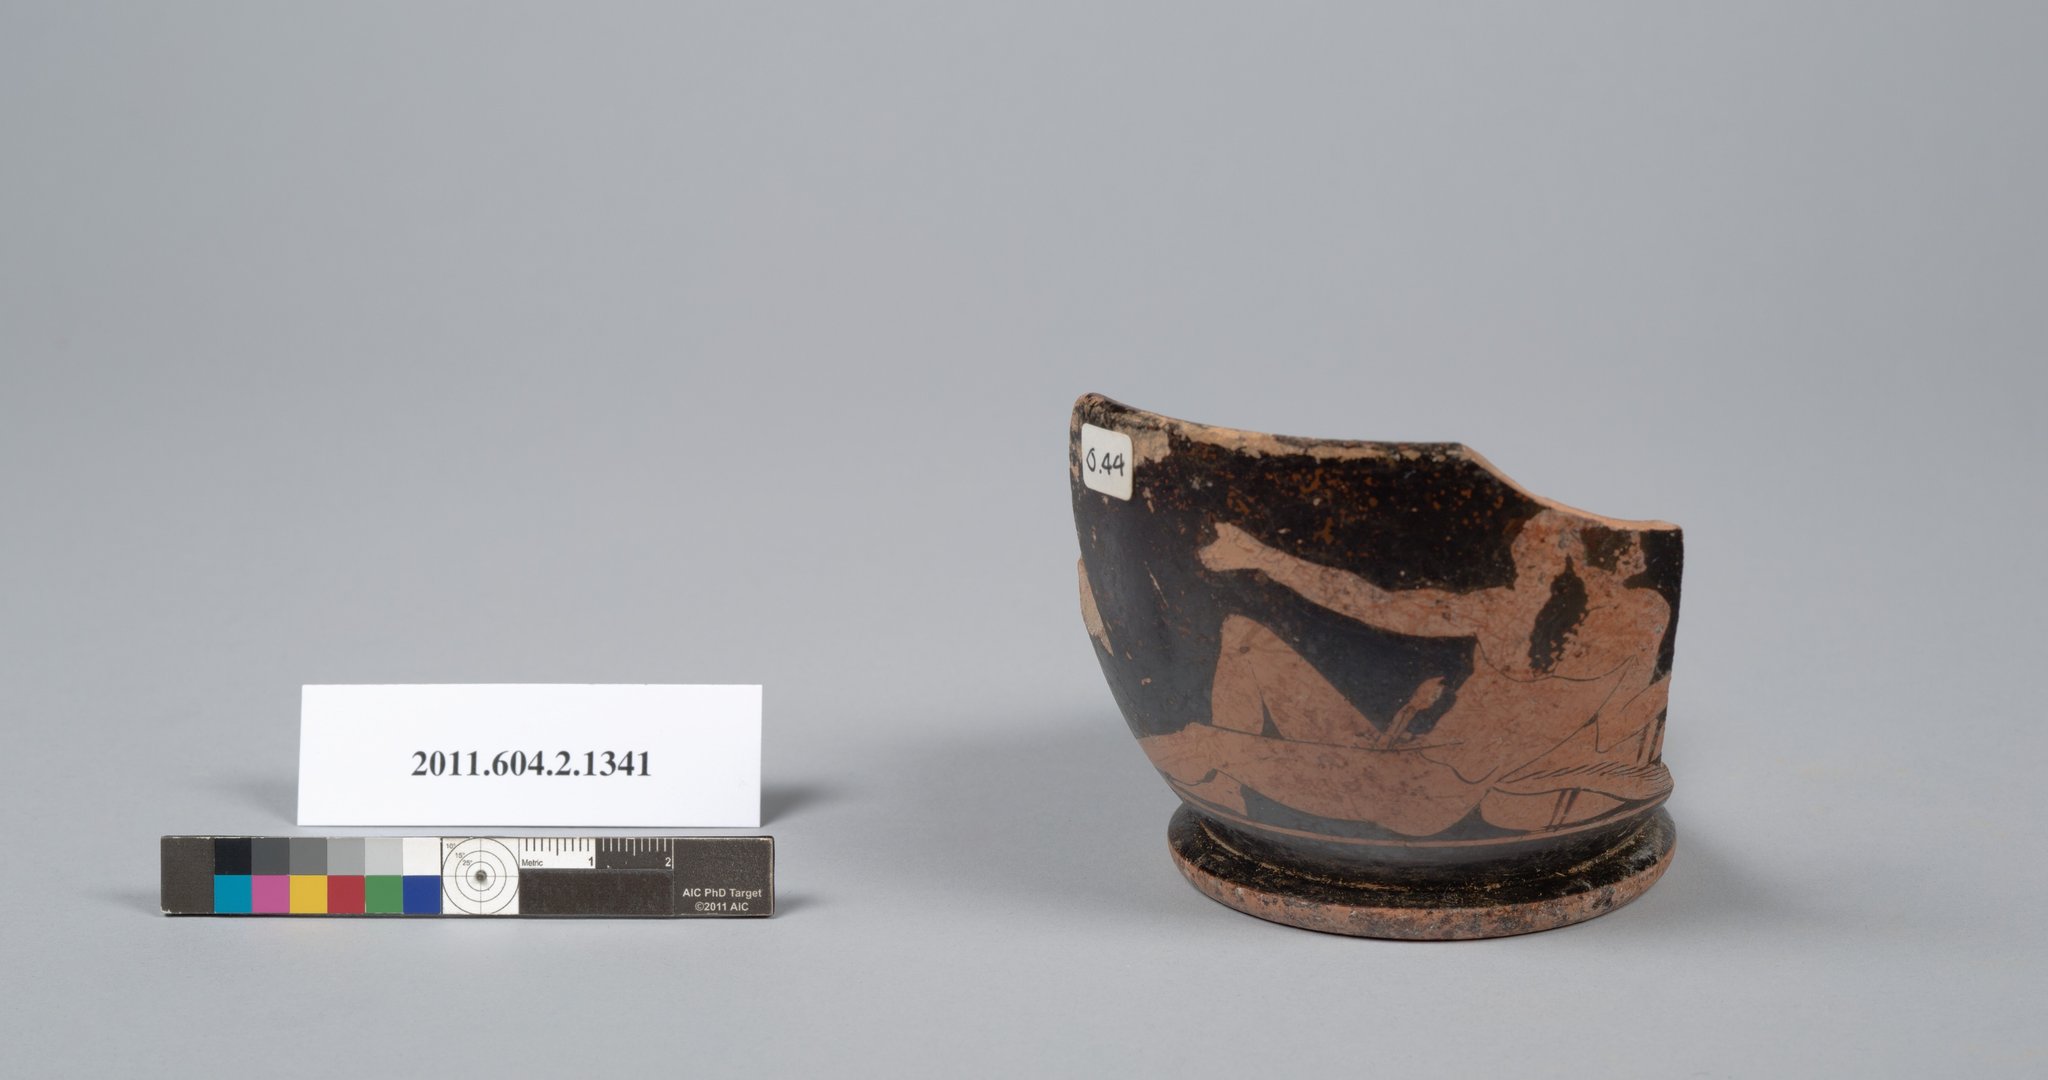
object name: skyphos fragment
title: Terracotta fragment of a skyphos (deep drinking cup)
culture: greek, attic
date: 475-451 BCE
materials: terracotta